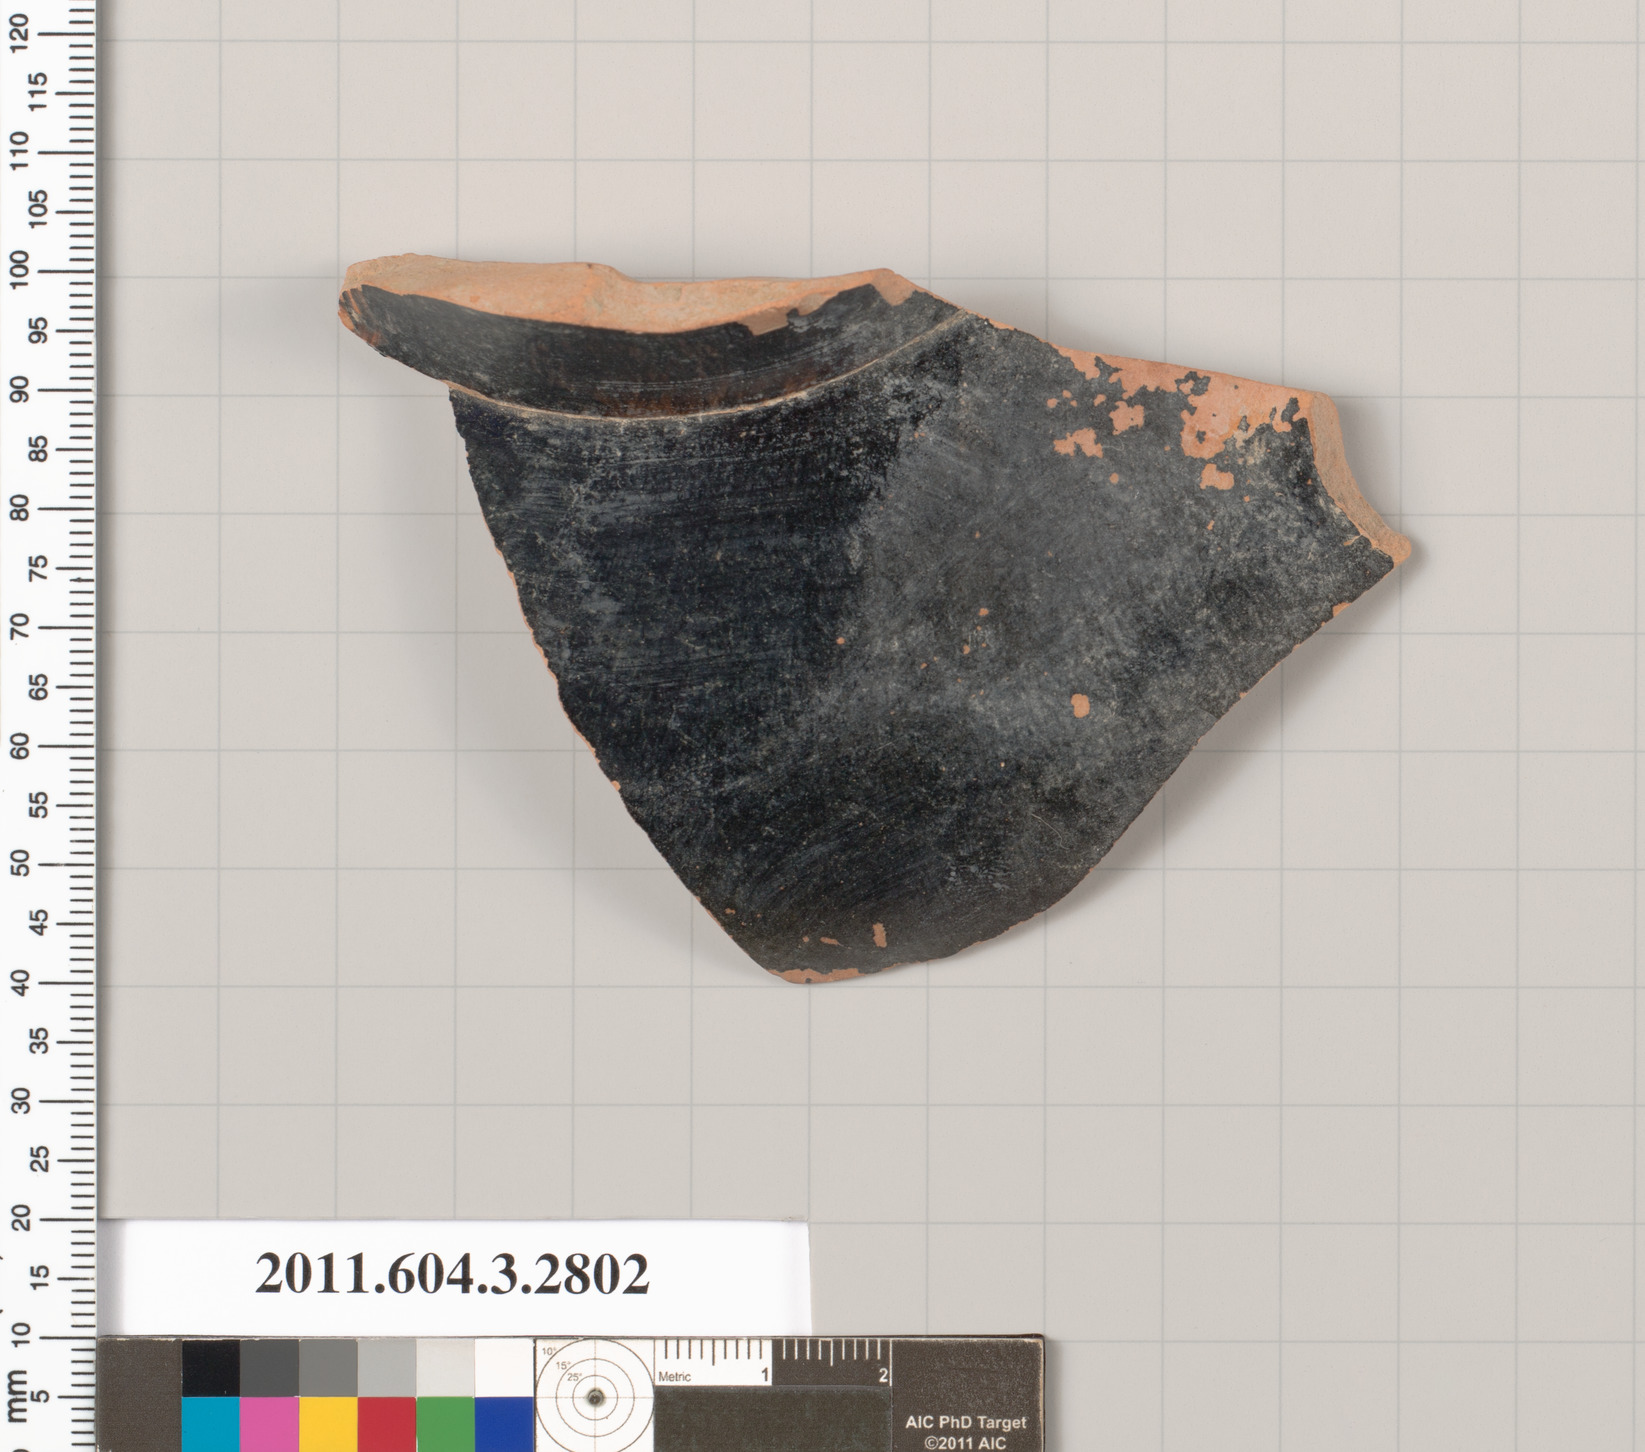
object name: oinochoe fragment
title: Terracotta fragment of an oinochoe (jug)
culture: greek, attic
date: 600-401 BCE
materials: terracotta